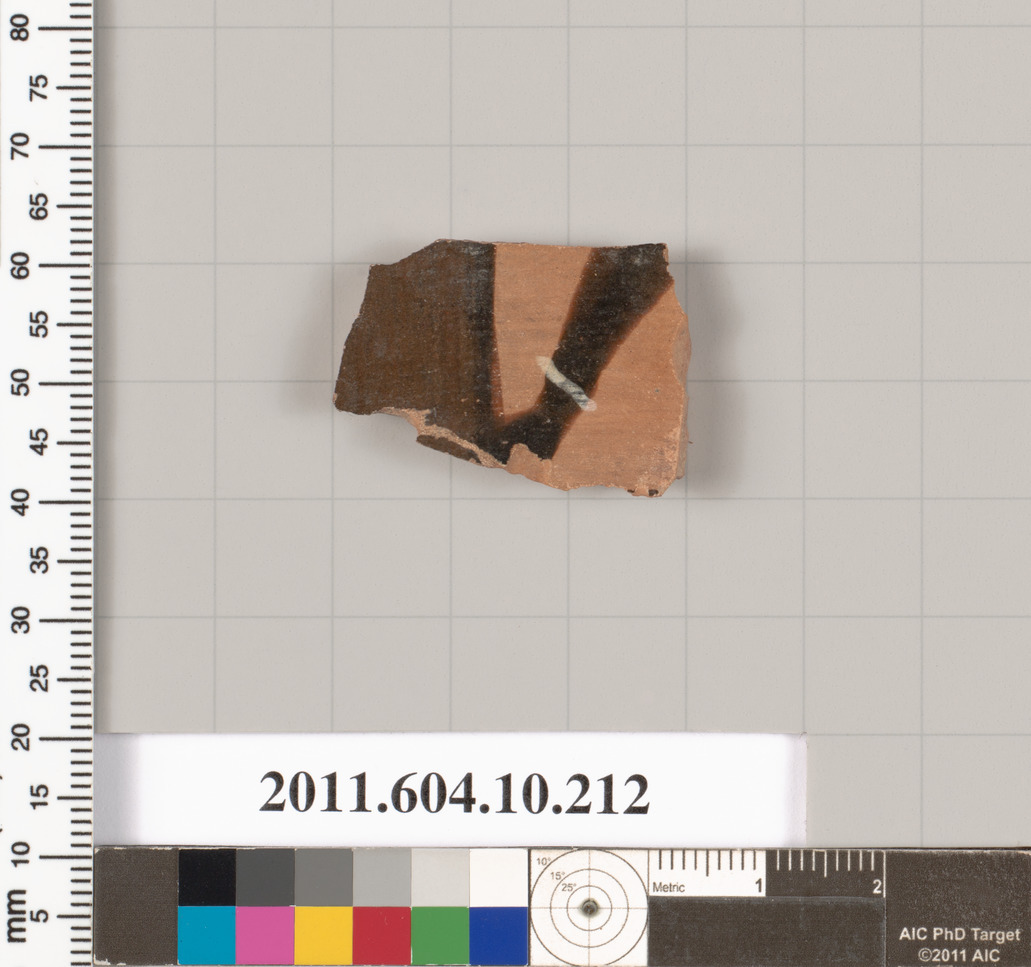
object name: amphora fragment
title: Terracotta fragment of an amphora (jar)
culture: etruscan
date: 600-501 BCE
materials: terracotta